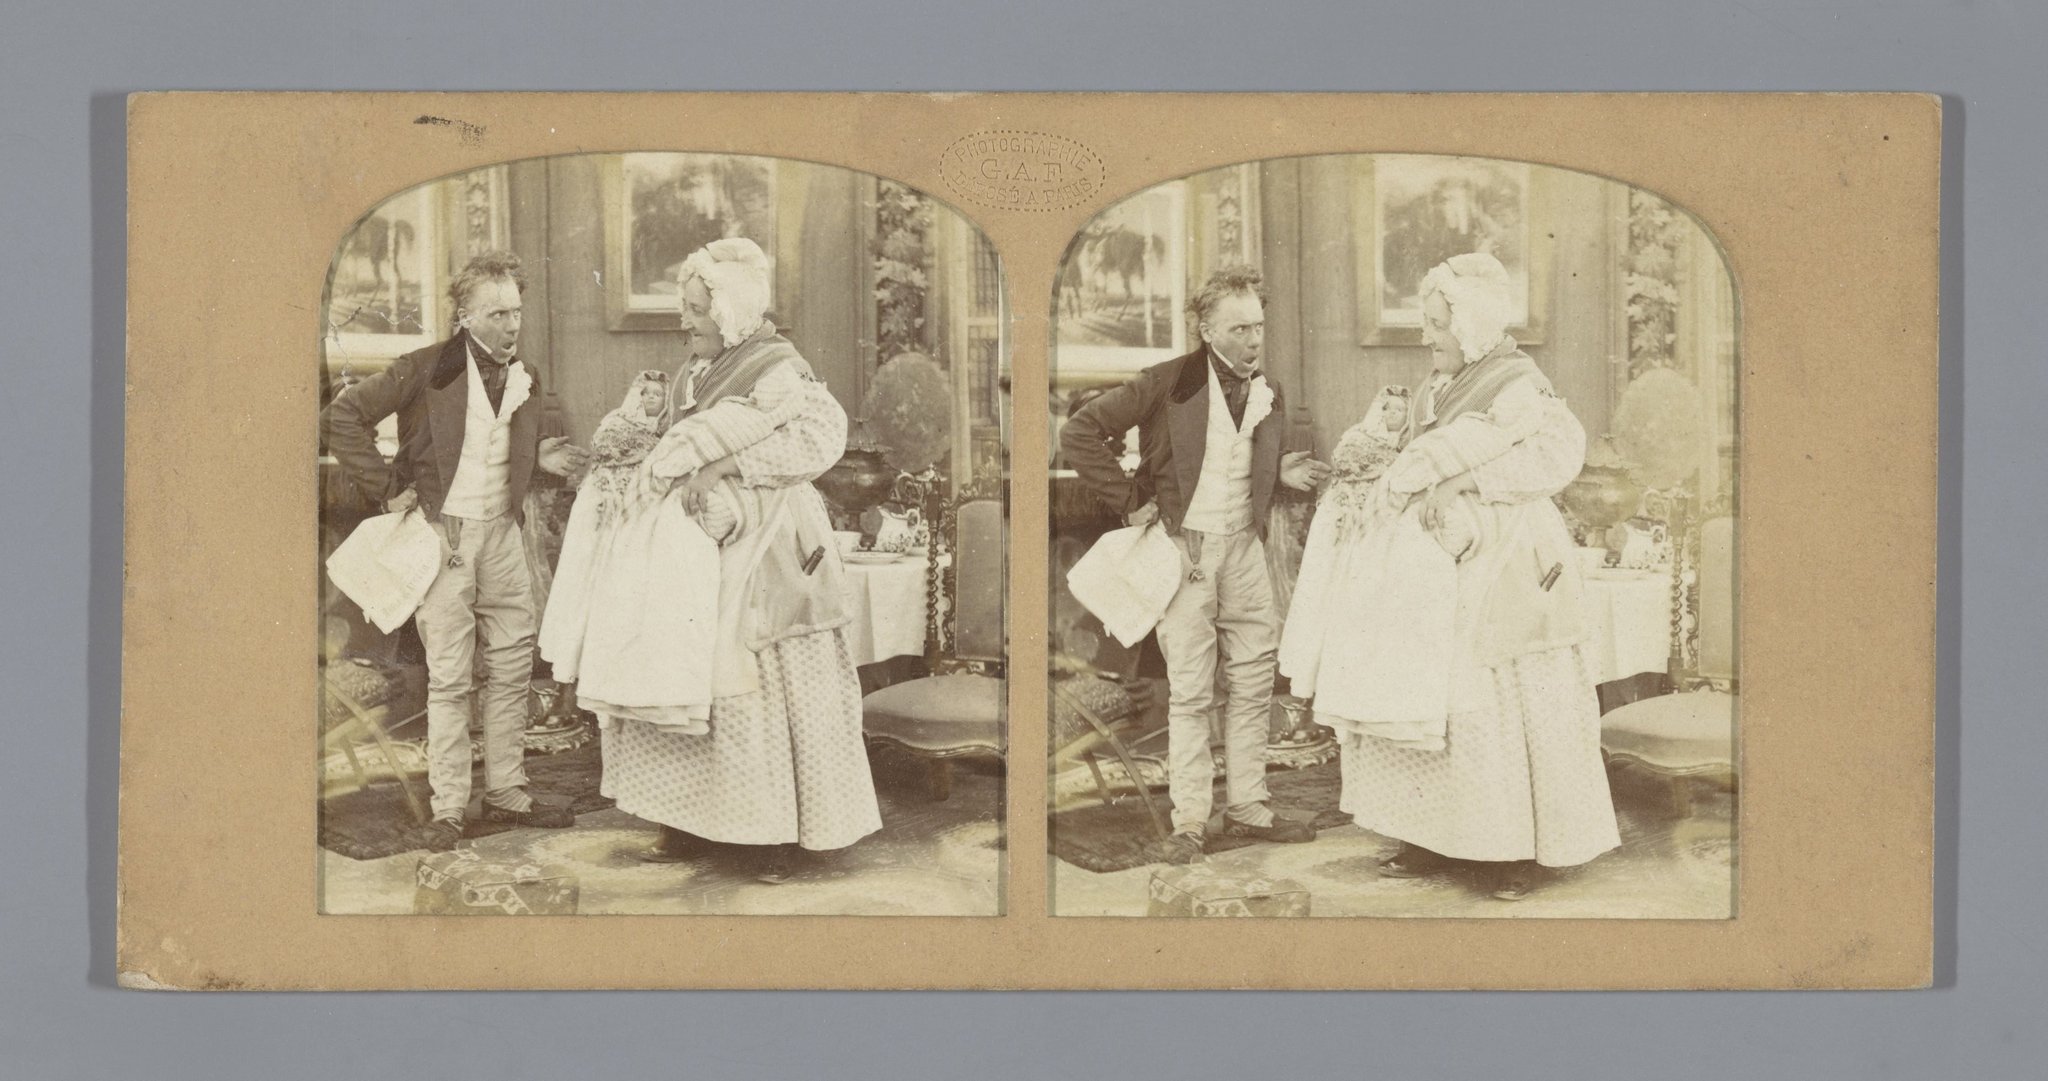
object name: tissue stereograph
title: Bediende toont twee baby's aan geschrokken vader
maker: florent grau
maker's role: manufacturer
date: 1855-1868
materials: cardboard, paper, photographic support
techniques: albumen print, hand coloring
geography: paris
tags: infant, baby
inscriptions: inscription: ‘DÉPOSÉ A PARIS’